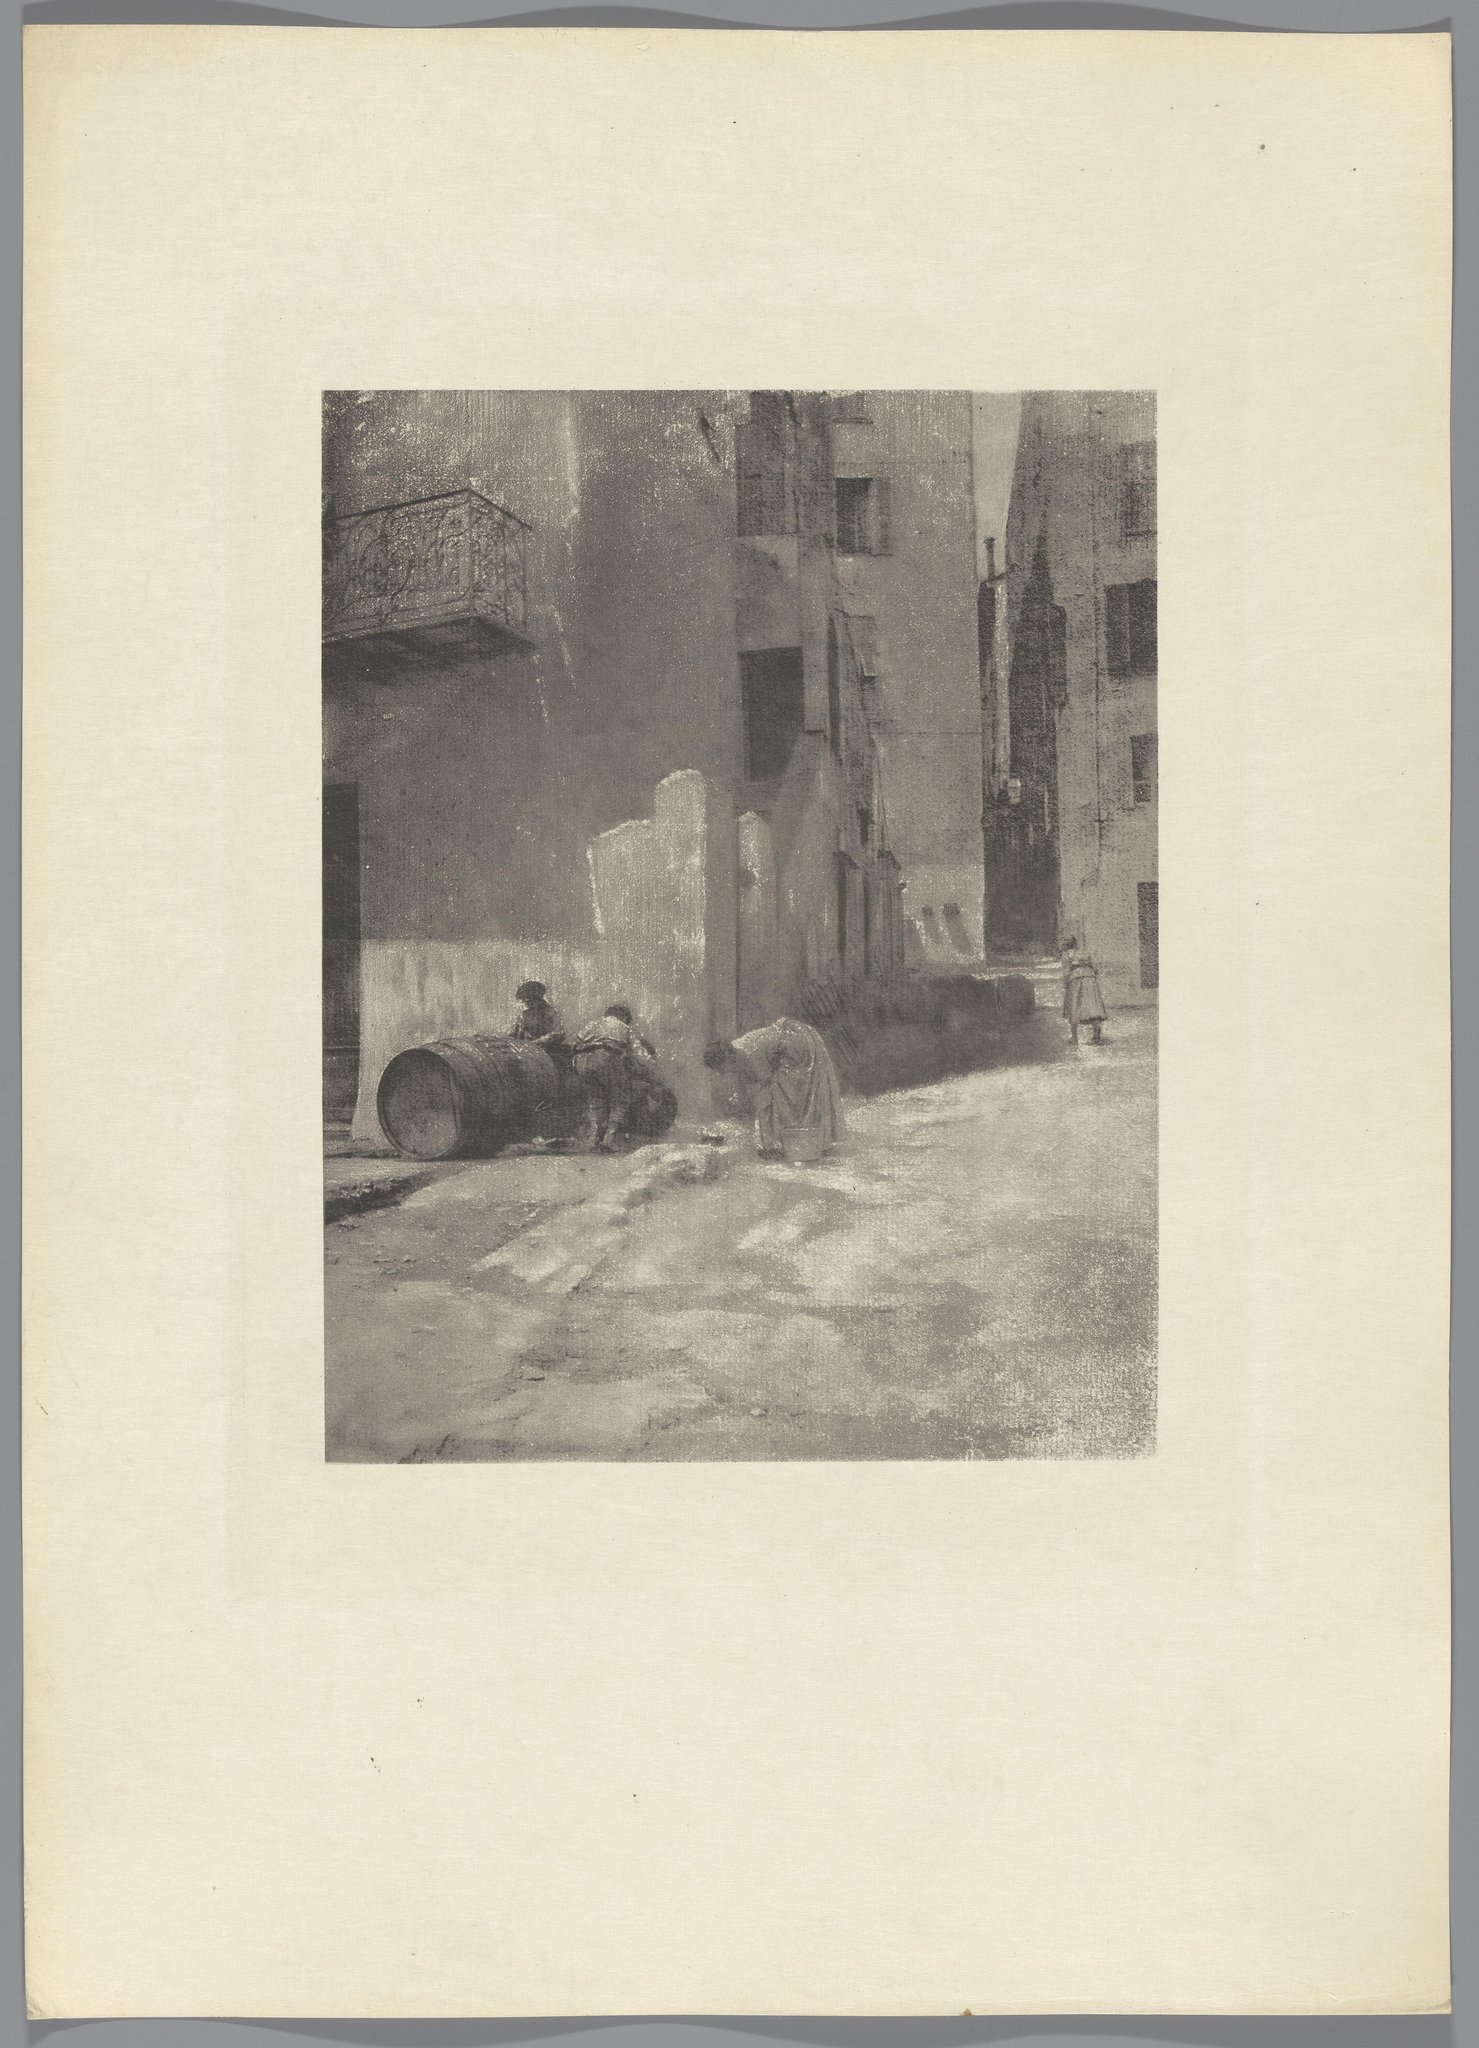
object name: photomechanical print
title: Coin de rue, à Menton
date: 1891-1896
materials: paper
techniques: photoaquatint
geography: menton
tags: street